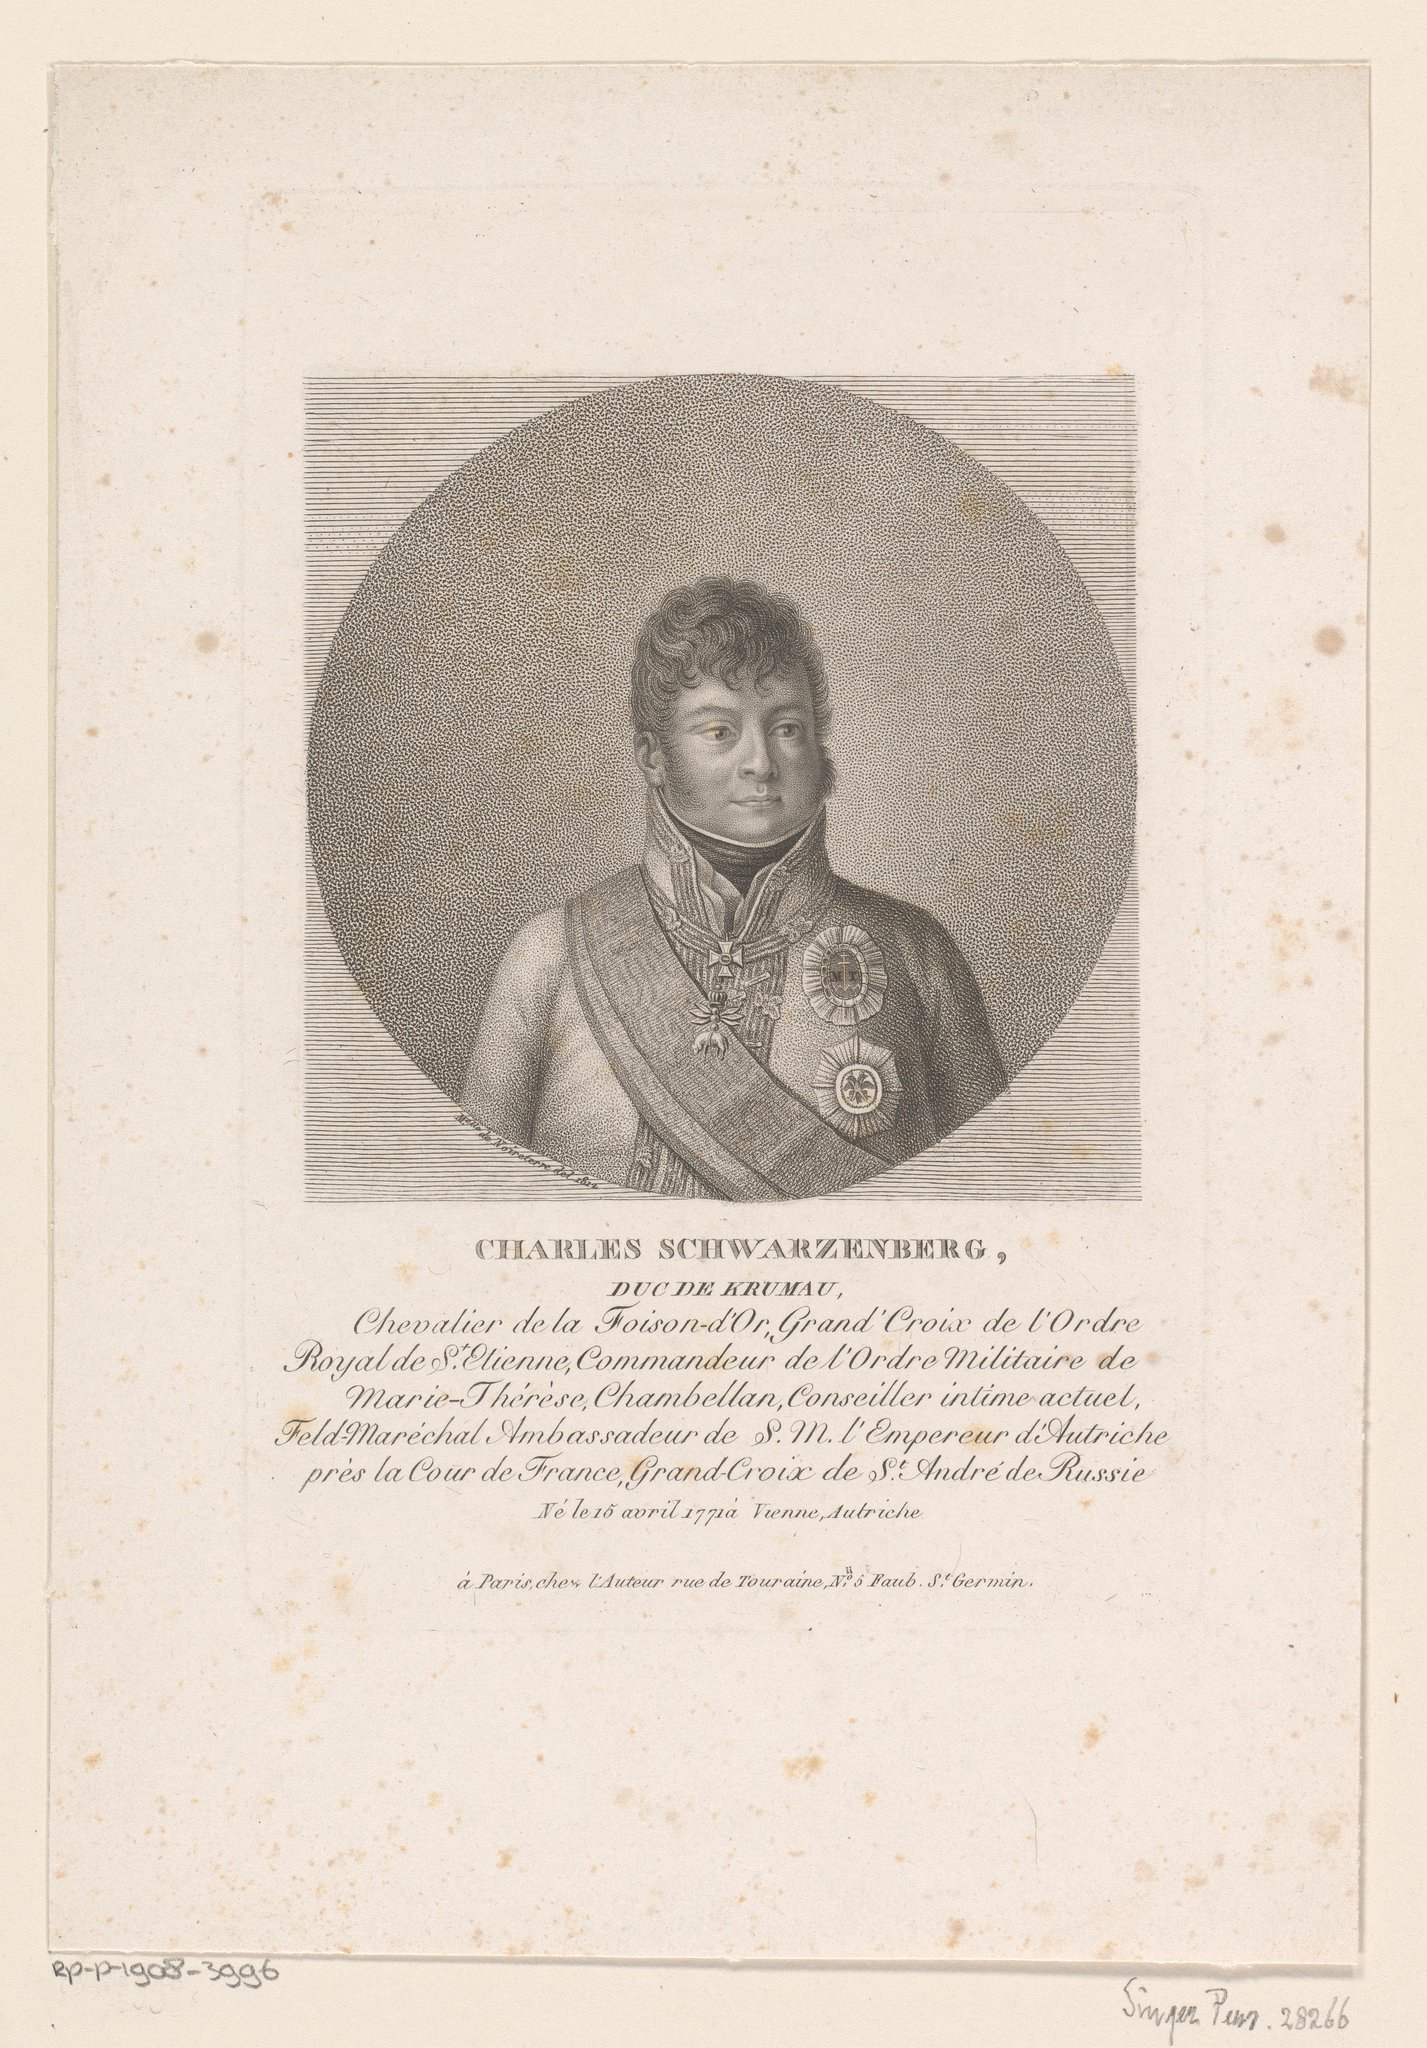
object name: print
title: Portret van Carl Philipp von Schwarzenberg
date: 1813-1836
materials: paper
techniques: engraving, etching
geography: netherlands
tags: vienna, commander-in-chief, general, marshal, historical persons, knighthood order of the golden fleece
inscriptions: collector's mark: Lugt 2228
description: Met zesregelig onderschrift in het Frans.